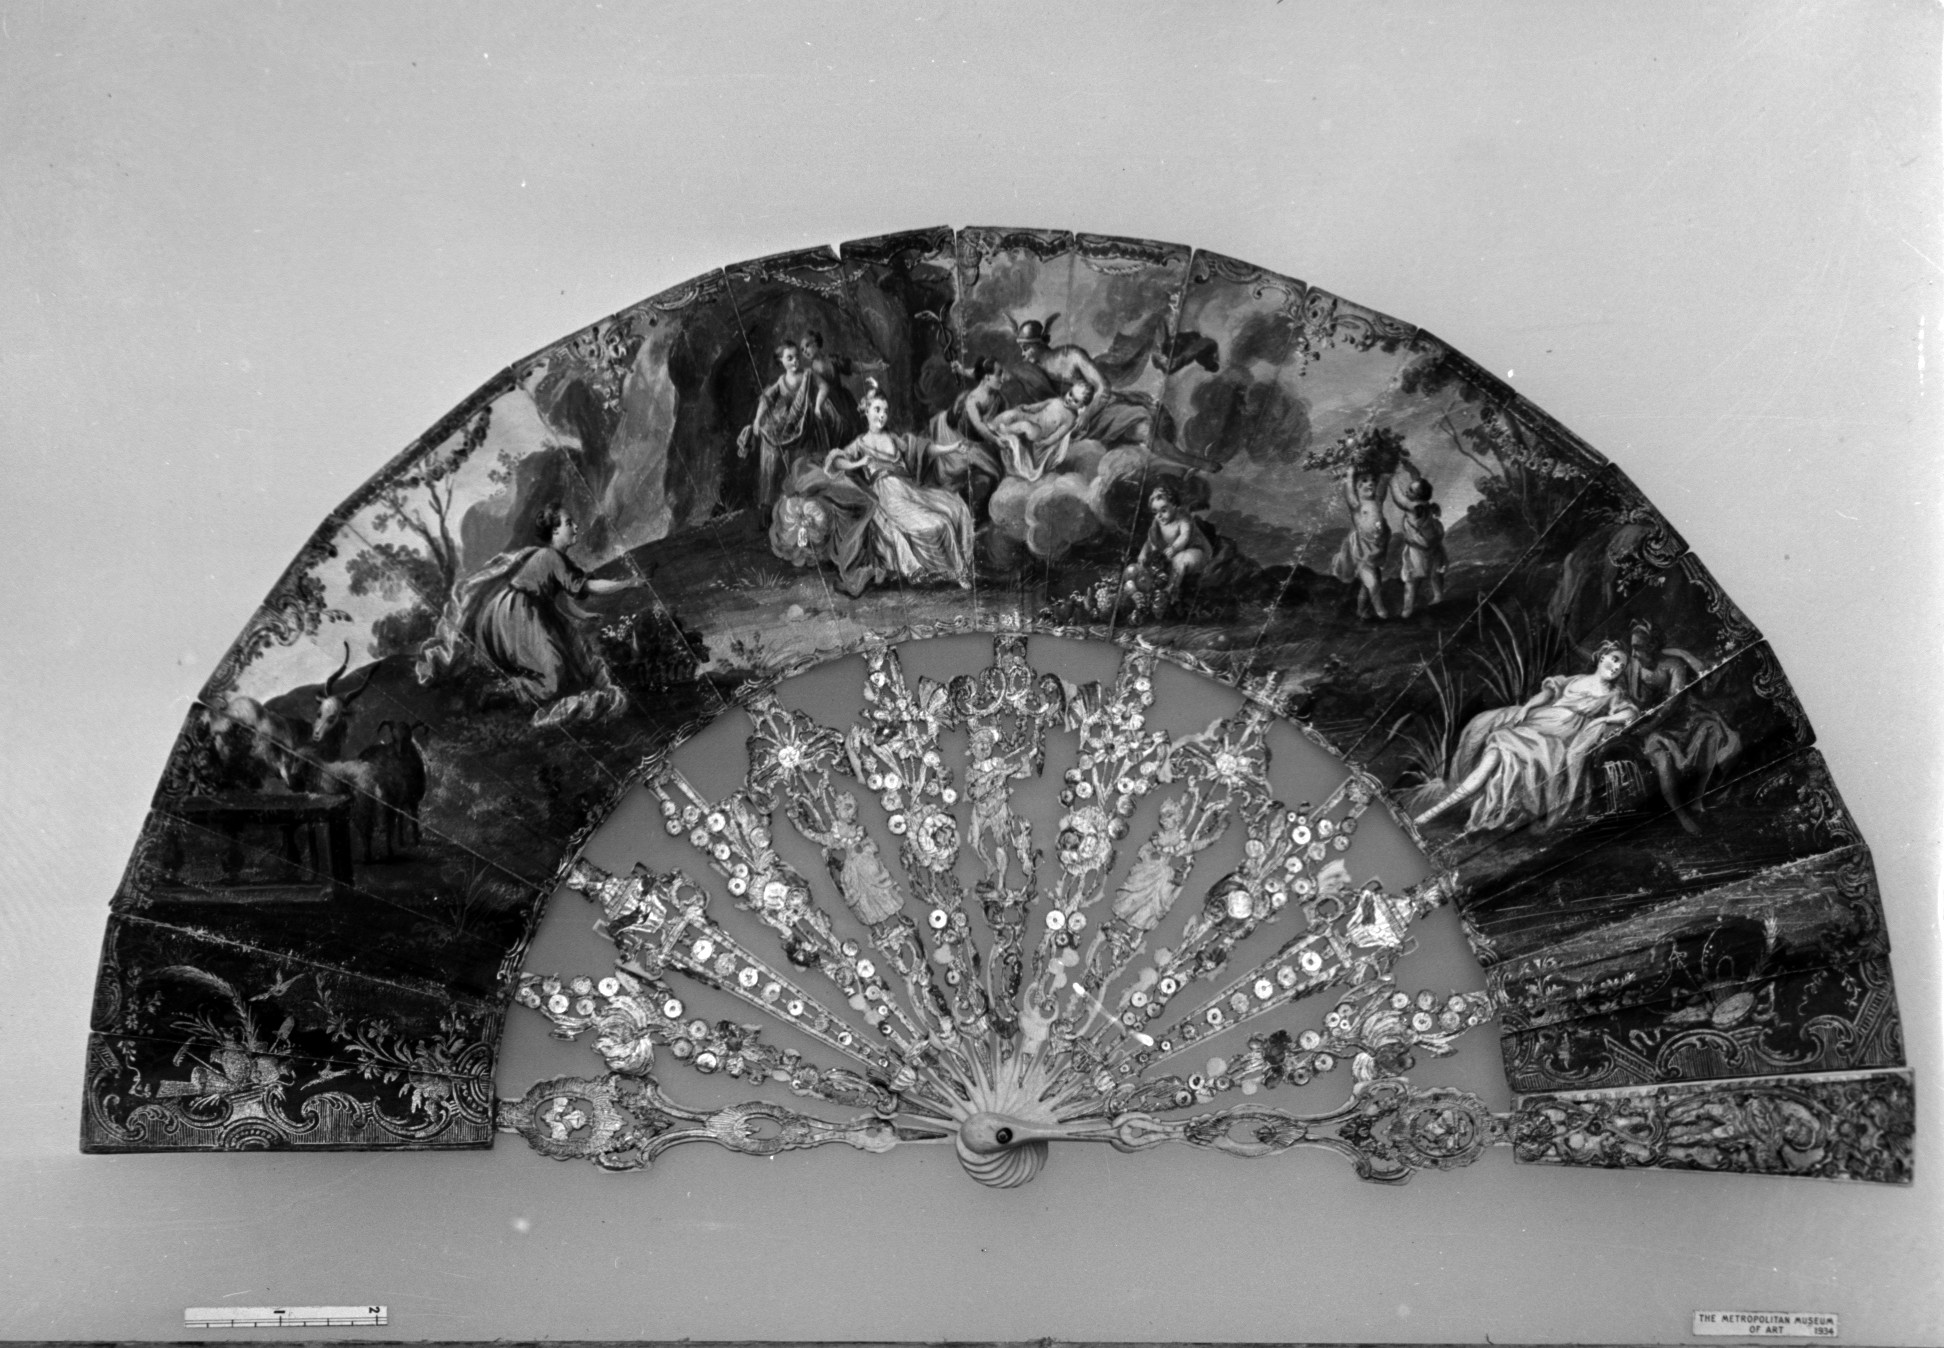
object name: fan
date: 1751-1775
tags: boys,infants,women,mercury